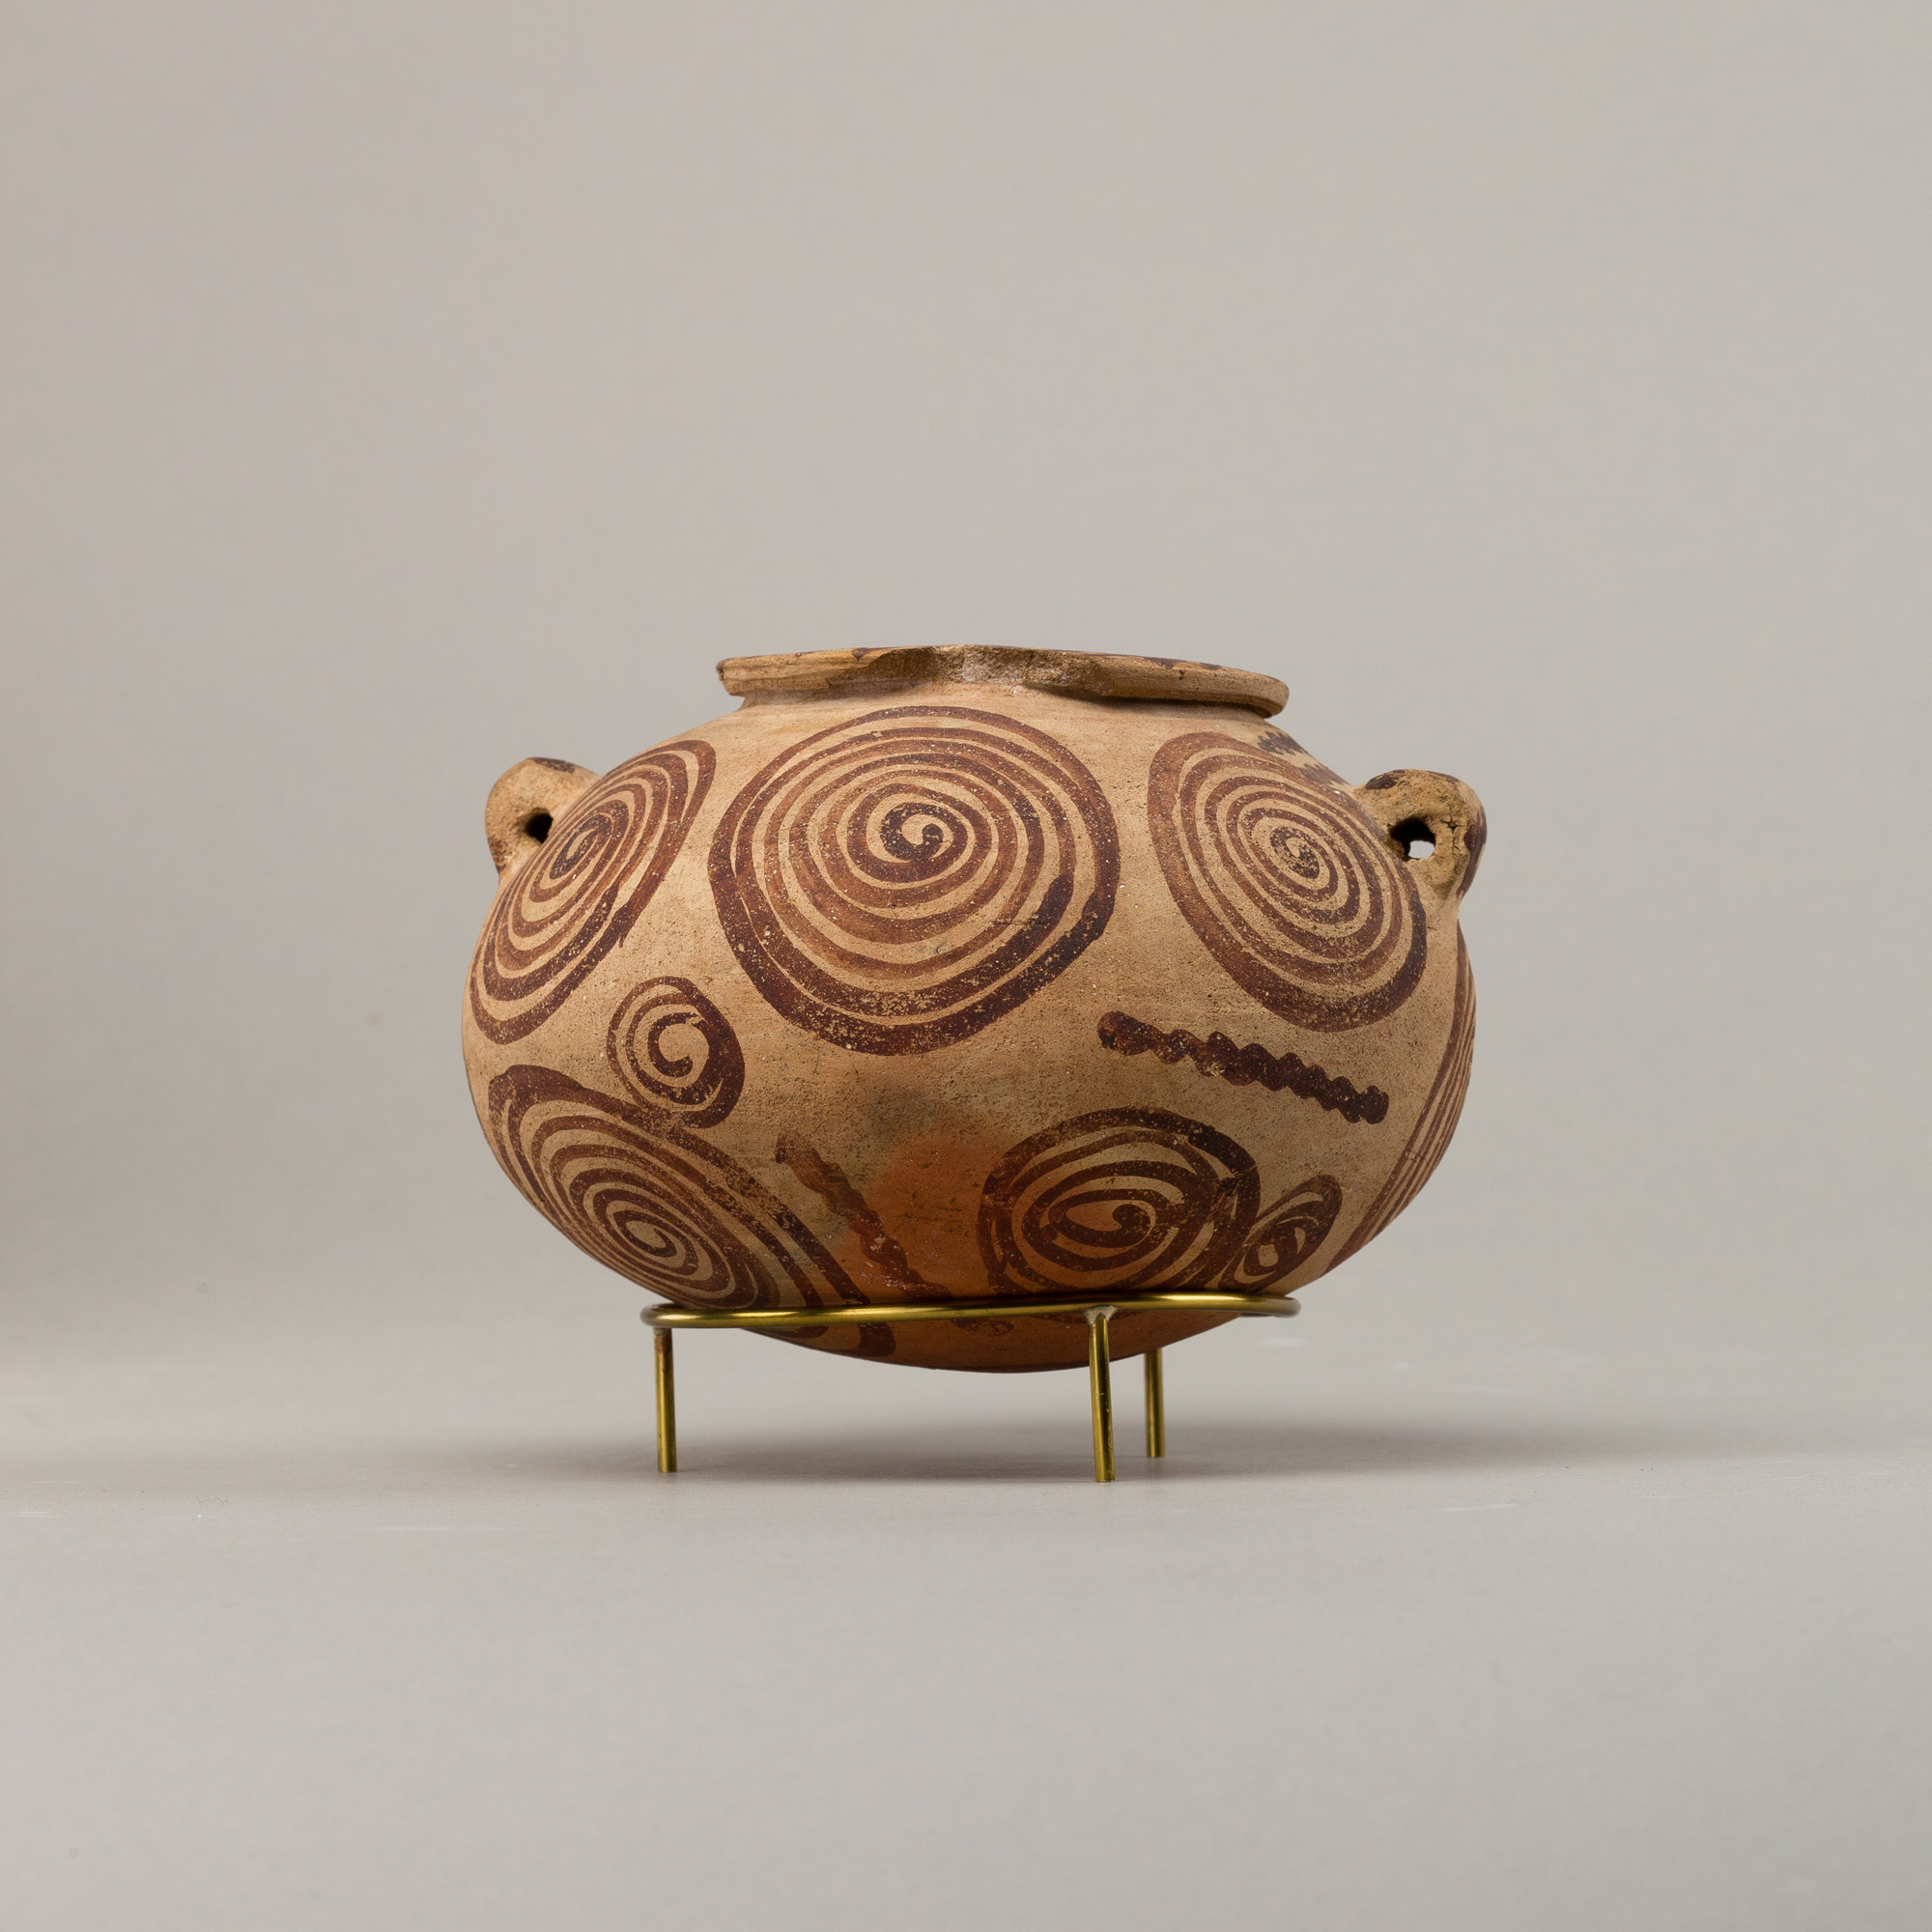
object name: bowl, spiral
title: Decorated ware bowl illustratiing spirals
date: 3850-2960 BCE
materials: paint, pottery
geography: egypt